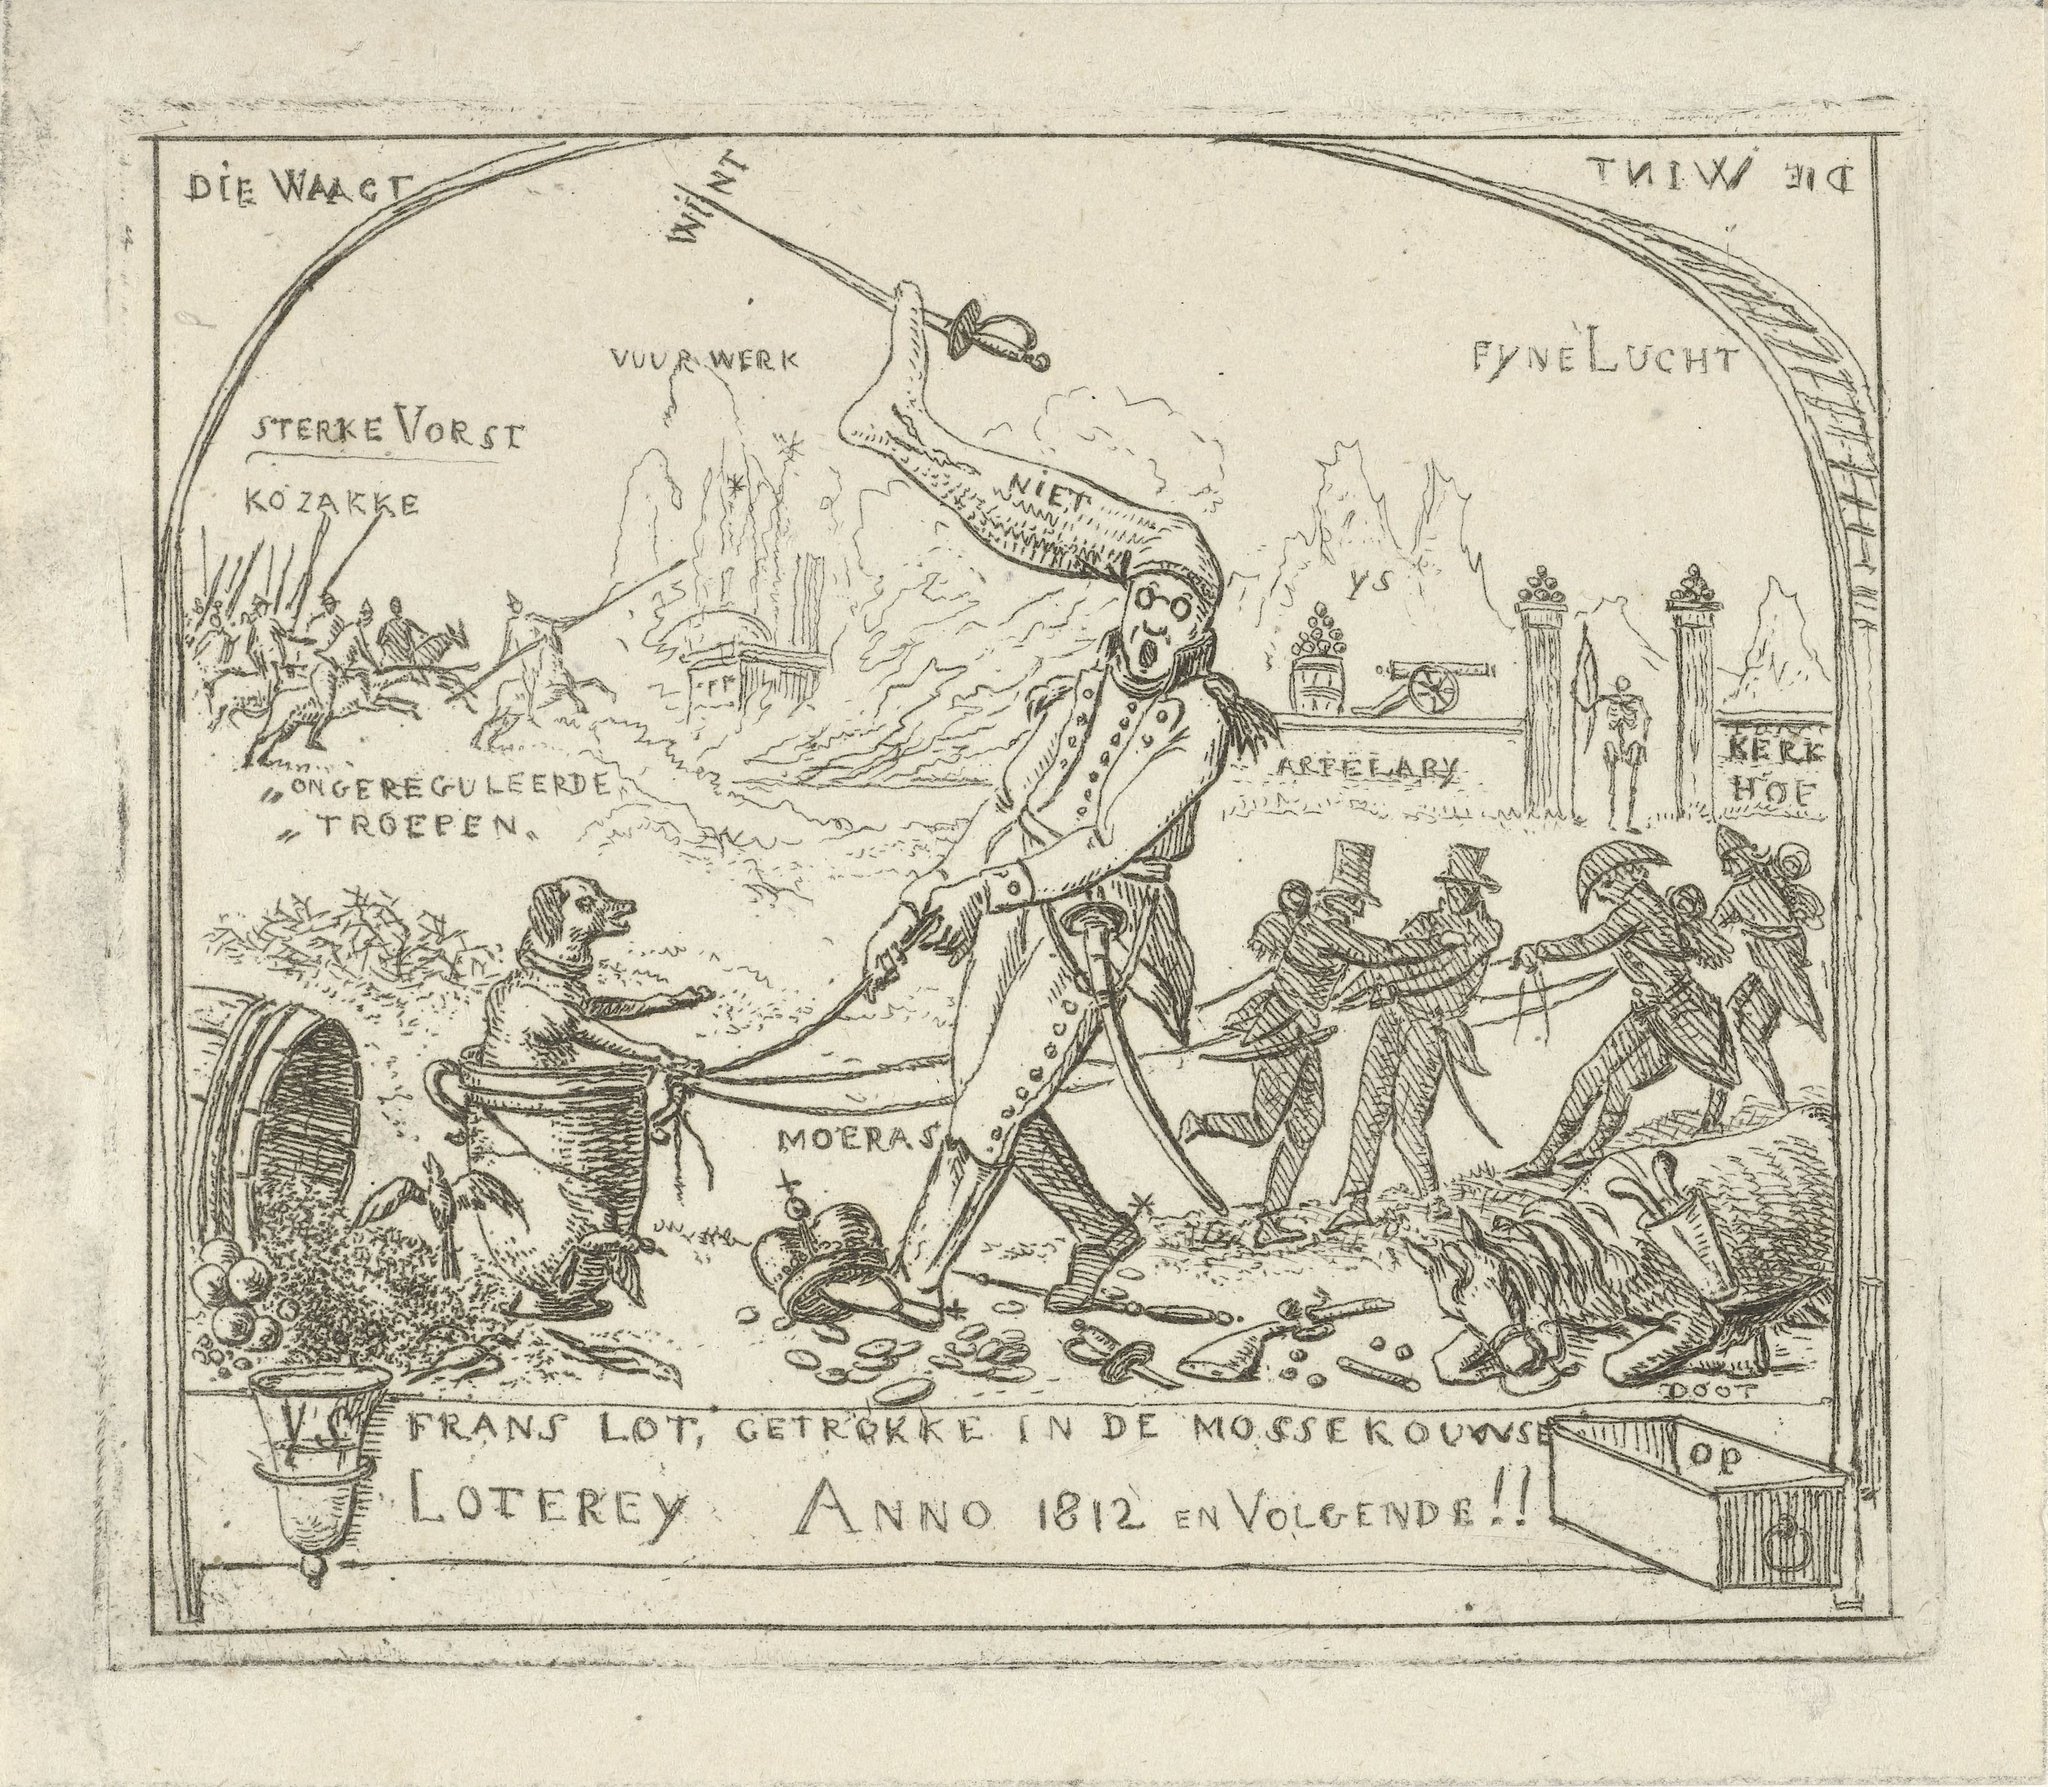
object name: print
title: Spotprenten op de nederlagen der Fransen in 1813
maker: hermanus fock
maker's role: conservator, draughtsman, painter, print maker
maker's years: 1766-1822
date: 1813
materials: paper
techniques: etching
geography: amsterdam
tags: napoleon i (emperor of the french)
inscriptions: collector's mark: Lugt 2760, collector's mark: Lugt 2228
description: Napoleon, met een sok op zijn hoofd, trekt een hond die in een bokaal zit door het moeras. Franse soldaten helpen hem. Op de achtergrond de Franse troepen die verslagen worden door de Kozakken, het vuurwerk, en een kerkhofportaal met een geraamte van een Franse soldaat. Onder de tekst: Frans lot, getrokke in de Mossekouwse Loterey anno 1812 en volgende!